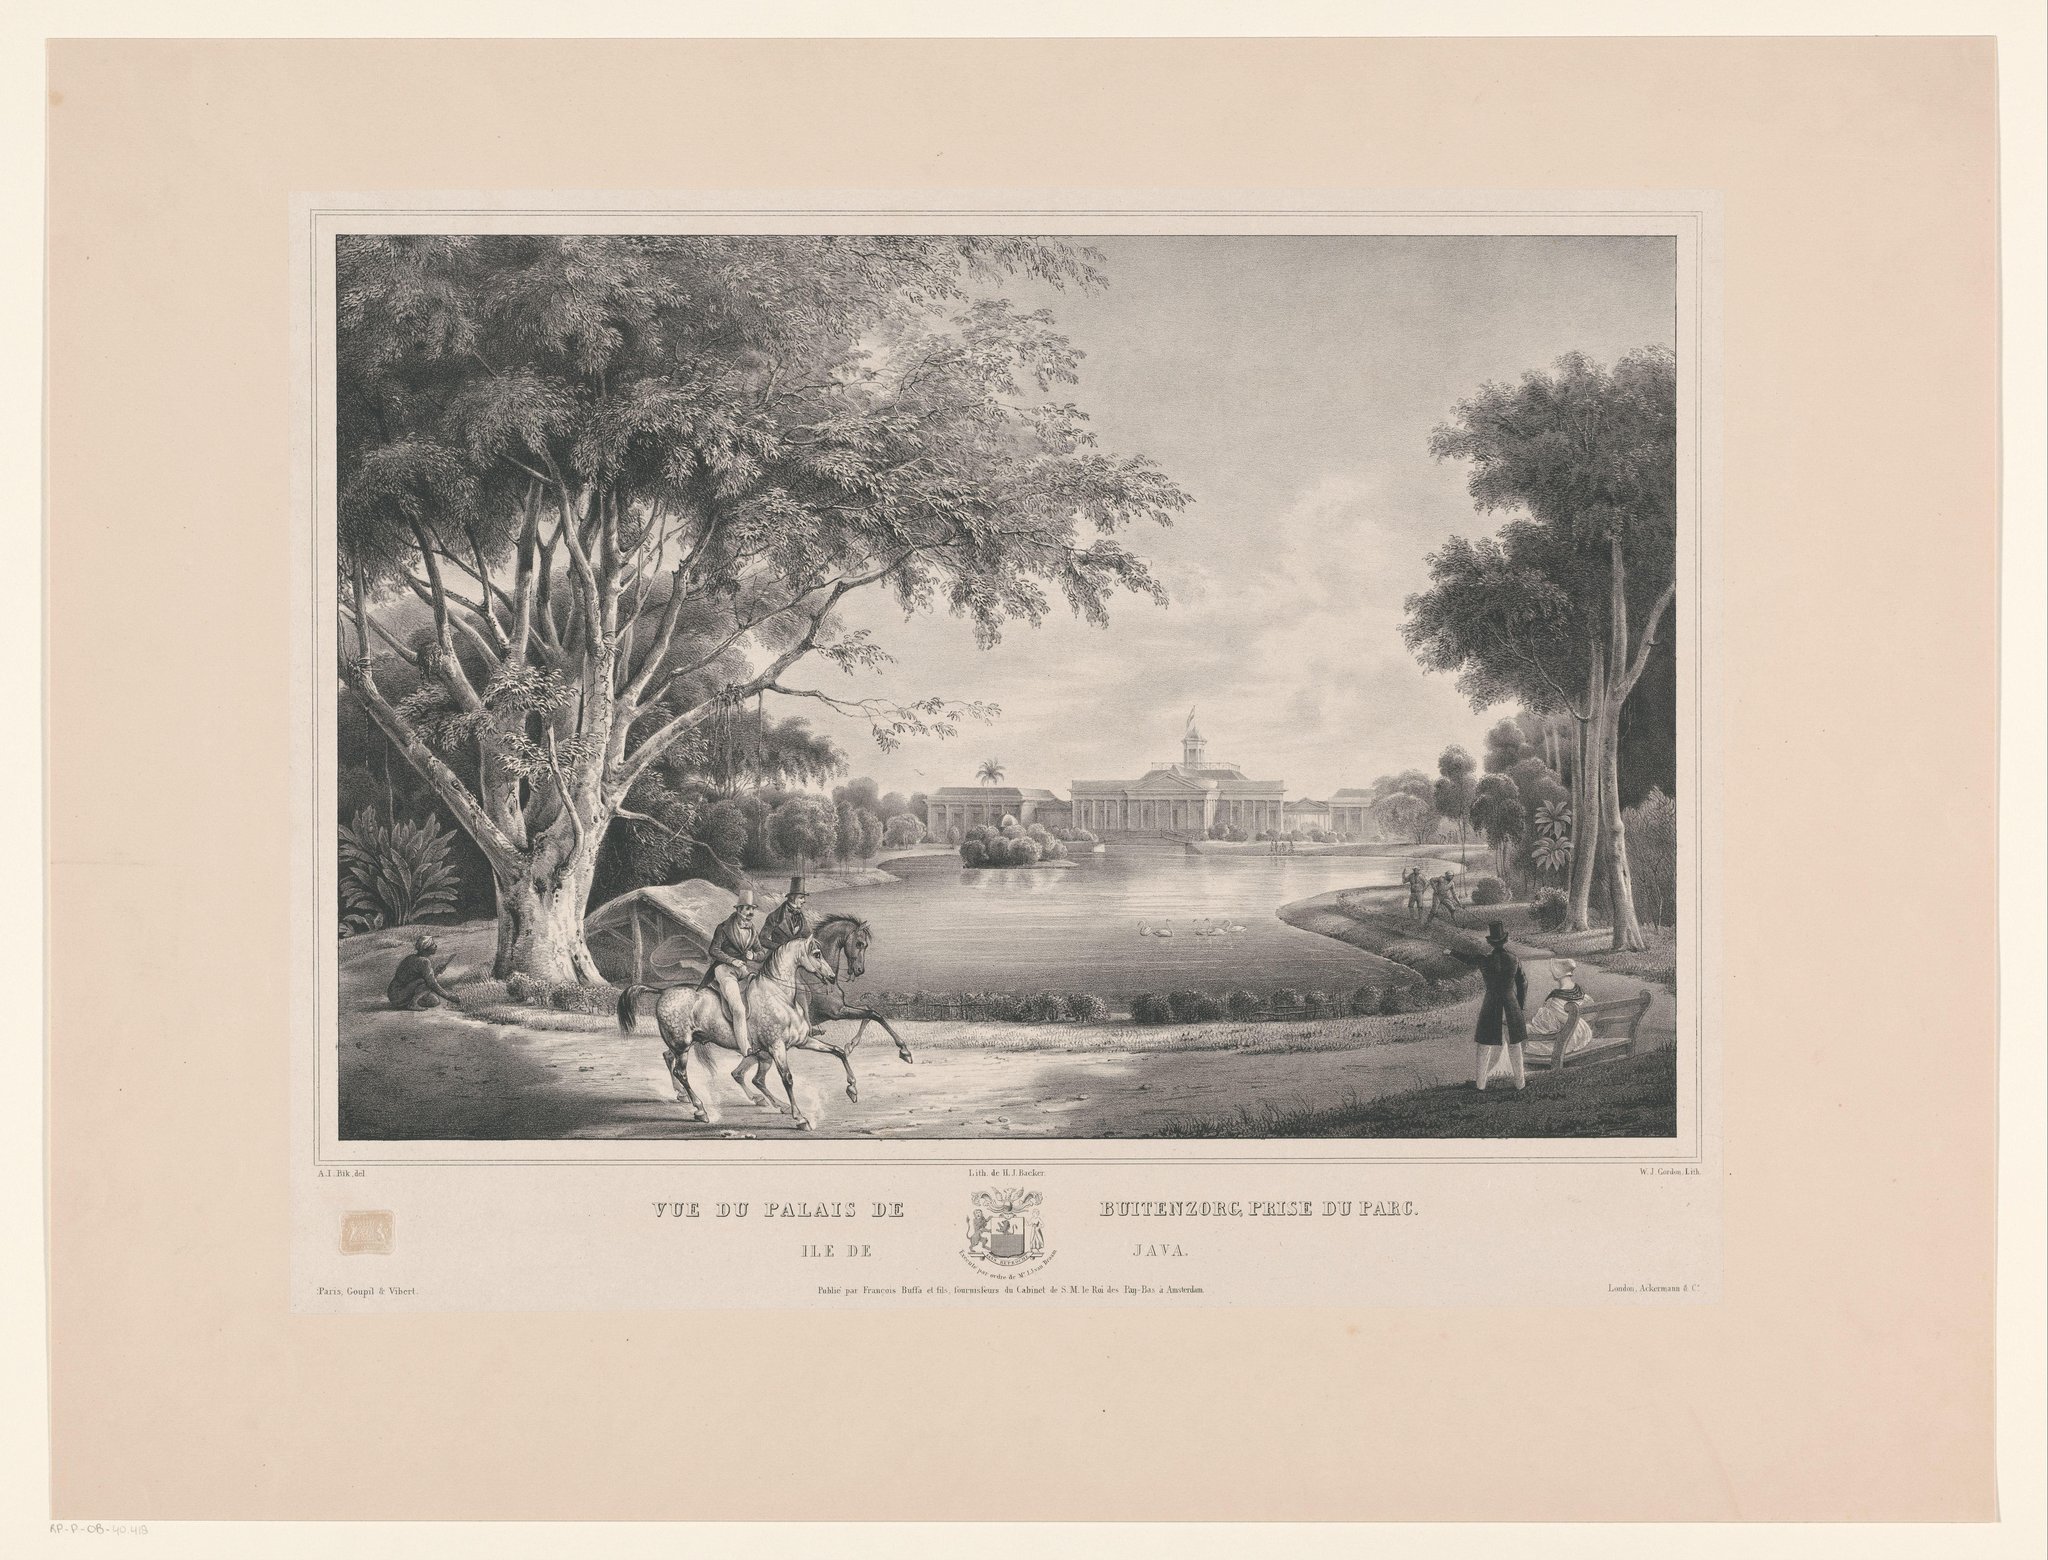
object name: print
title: Vues de Java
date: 1842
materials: paper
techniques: lithograph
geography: paris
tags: rural housing, e.g. country-house, villa, cottage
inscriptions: collector's mark: Lugt 2165, check stamp: ‘François Buffa & Fils Fournisseurs du Roi’, collector's mark: Lugt 2228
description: Het paleis in de Plantentuin te Buitenzorg (West-Java) met op de voorgrond twee mannen te paard en recreërende mensen.